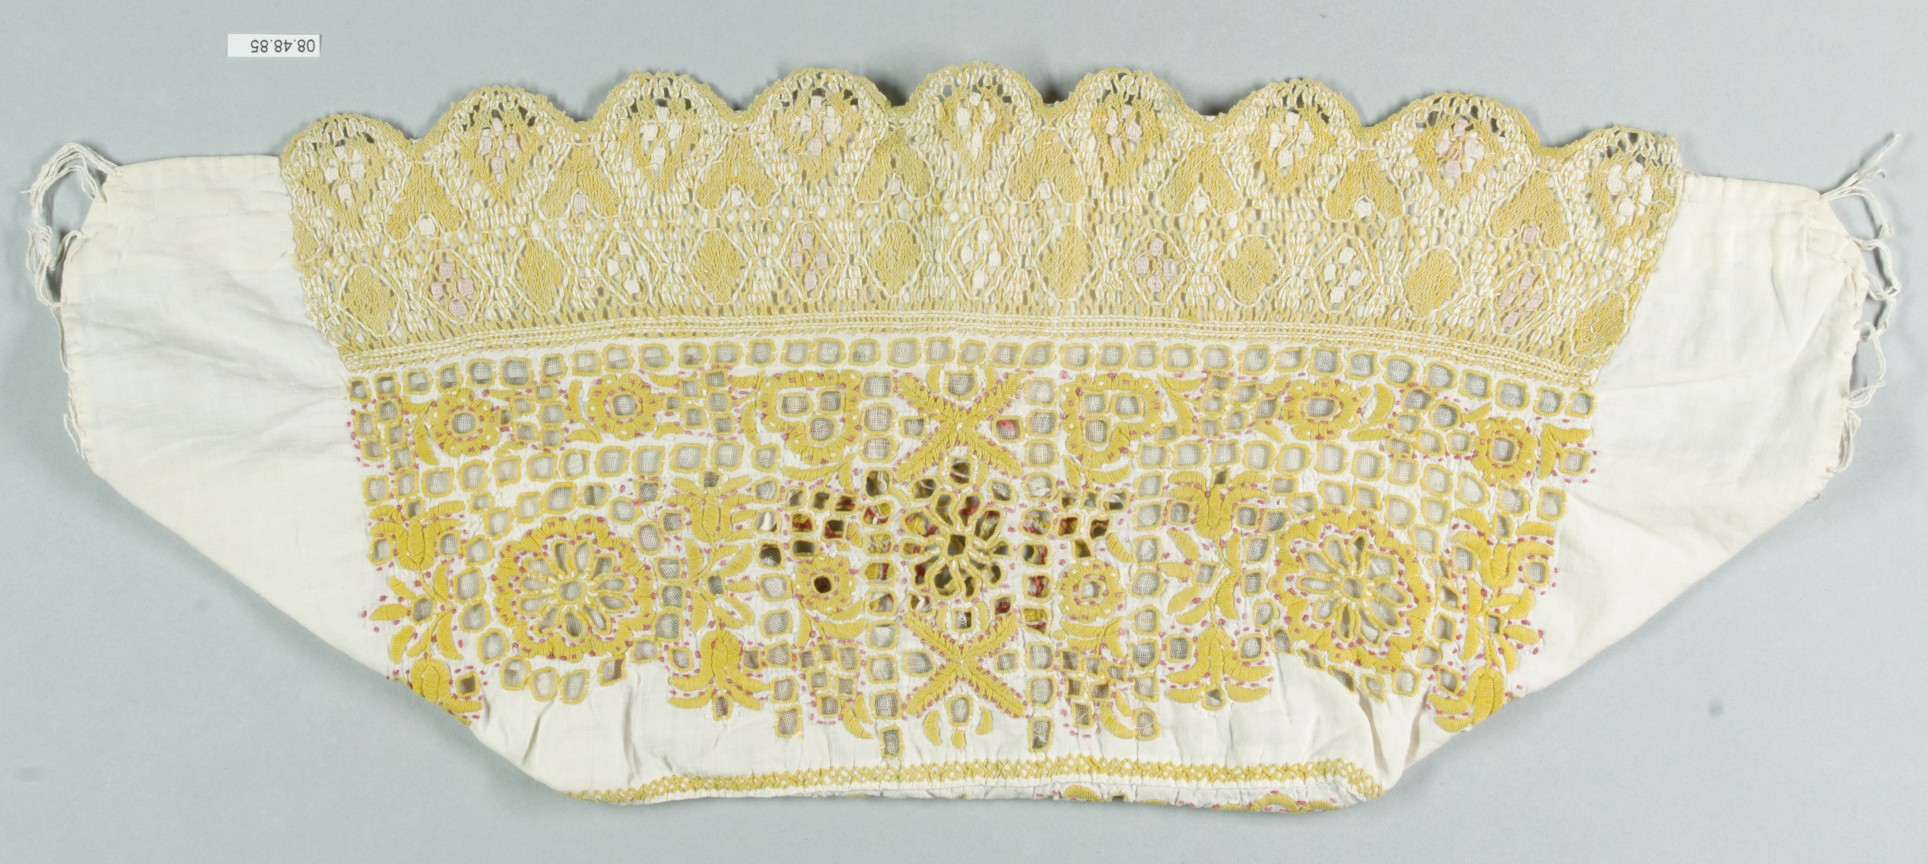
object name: cap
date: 1801-1900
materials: cotton